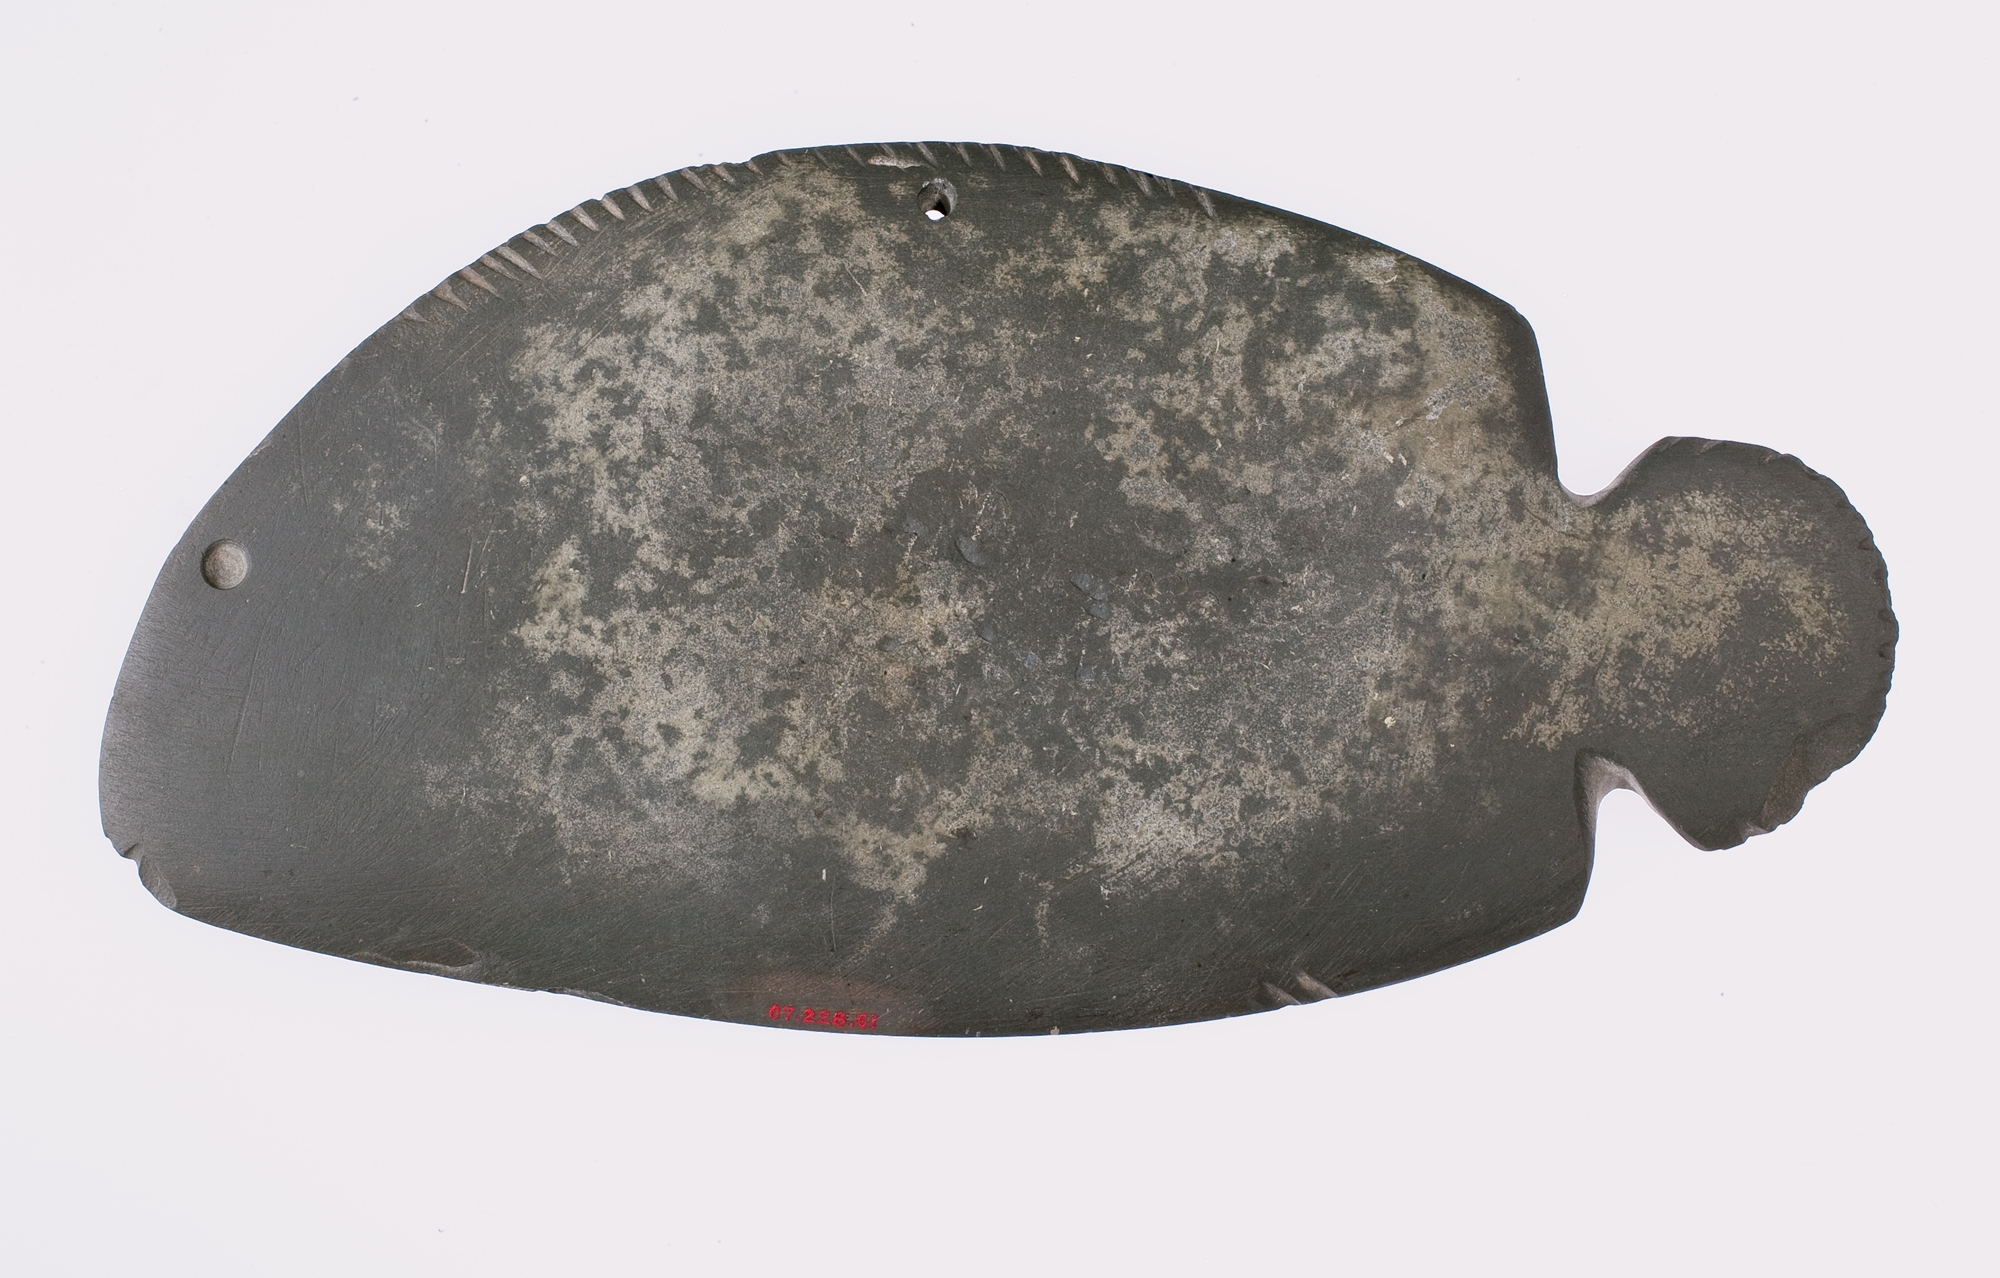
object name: palette, fish shaped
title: Palette shaped like a fish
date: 3650-3300 BCE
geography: egypt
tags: fish